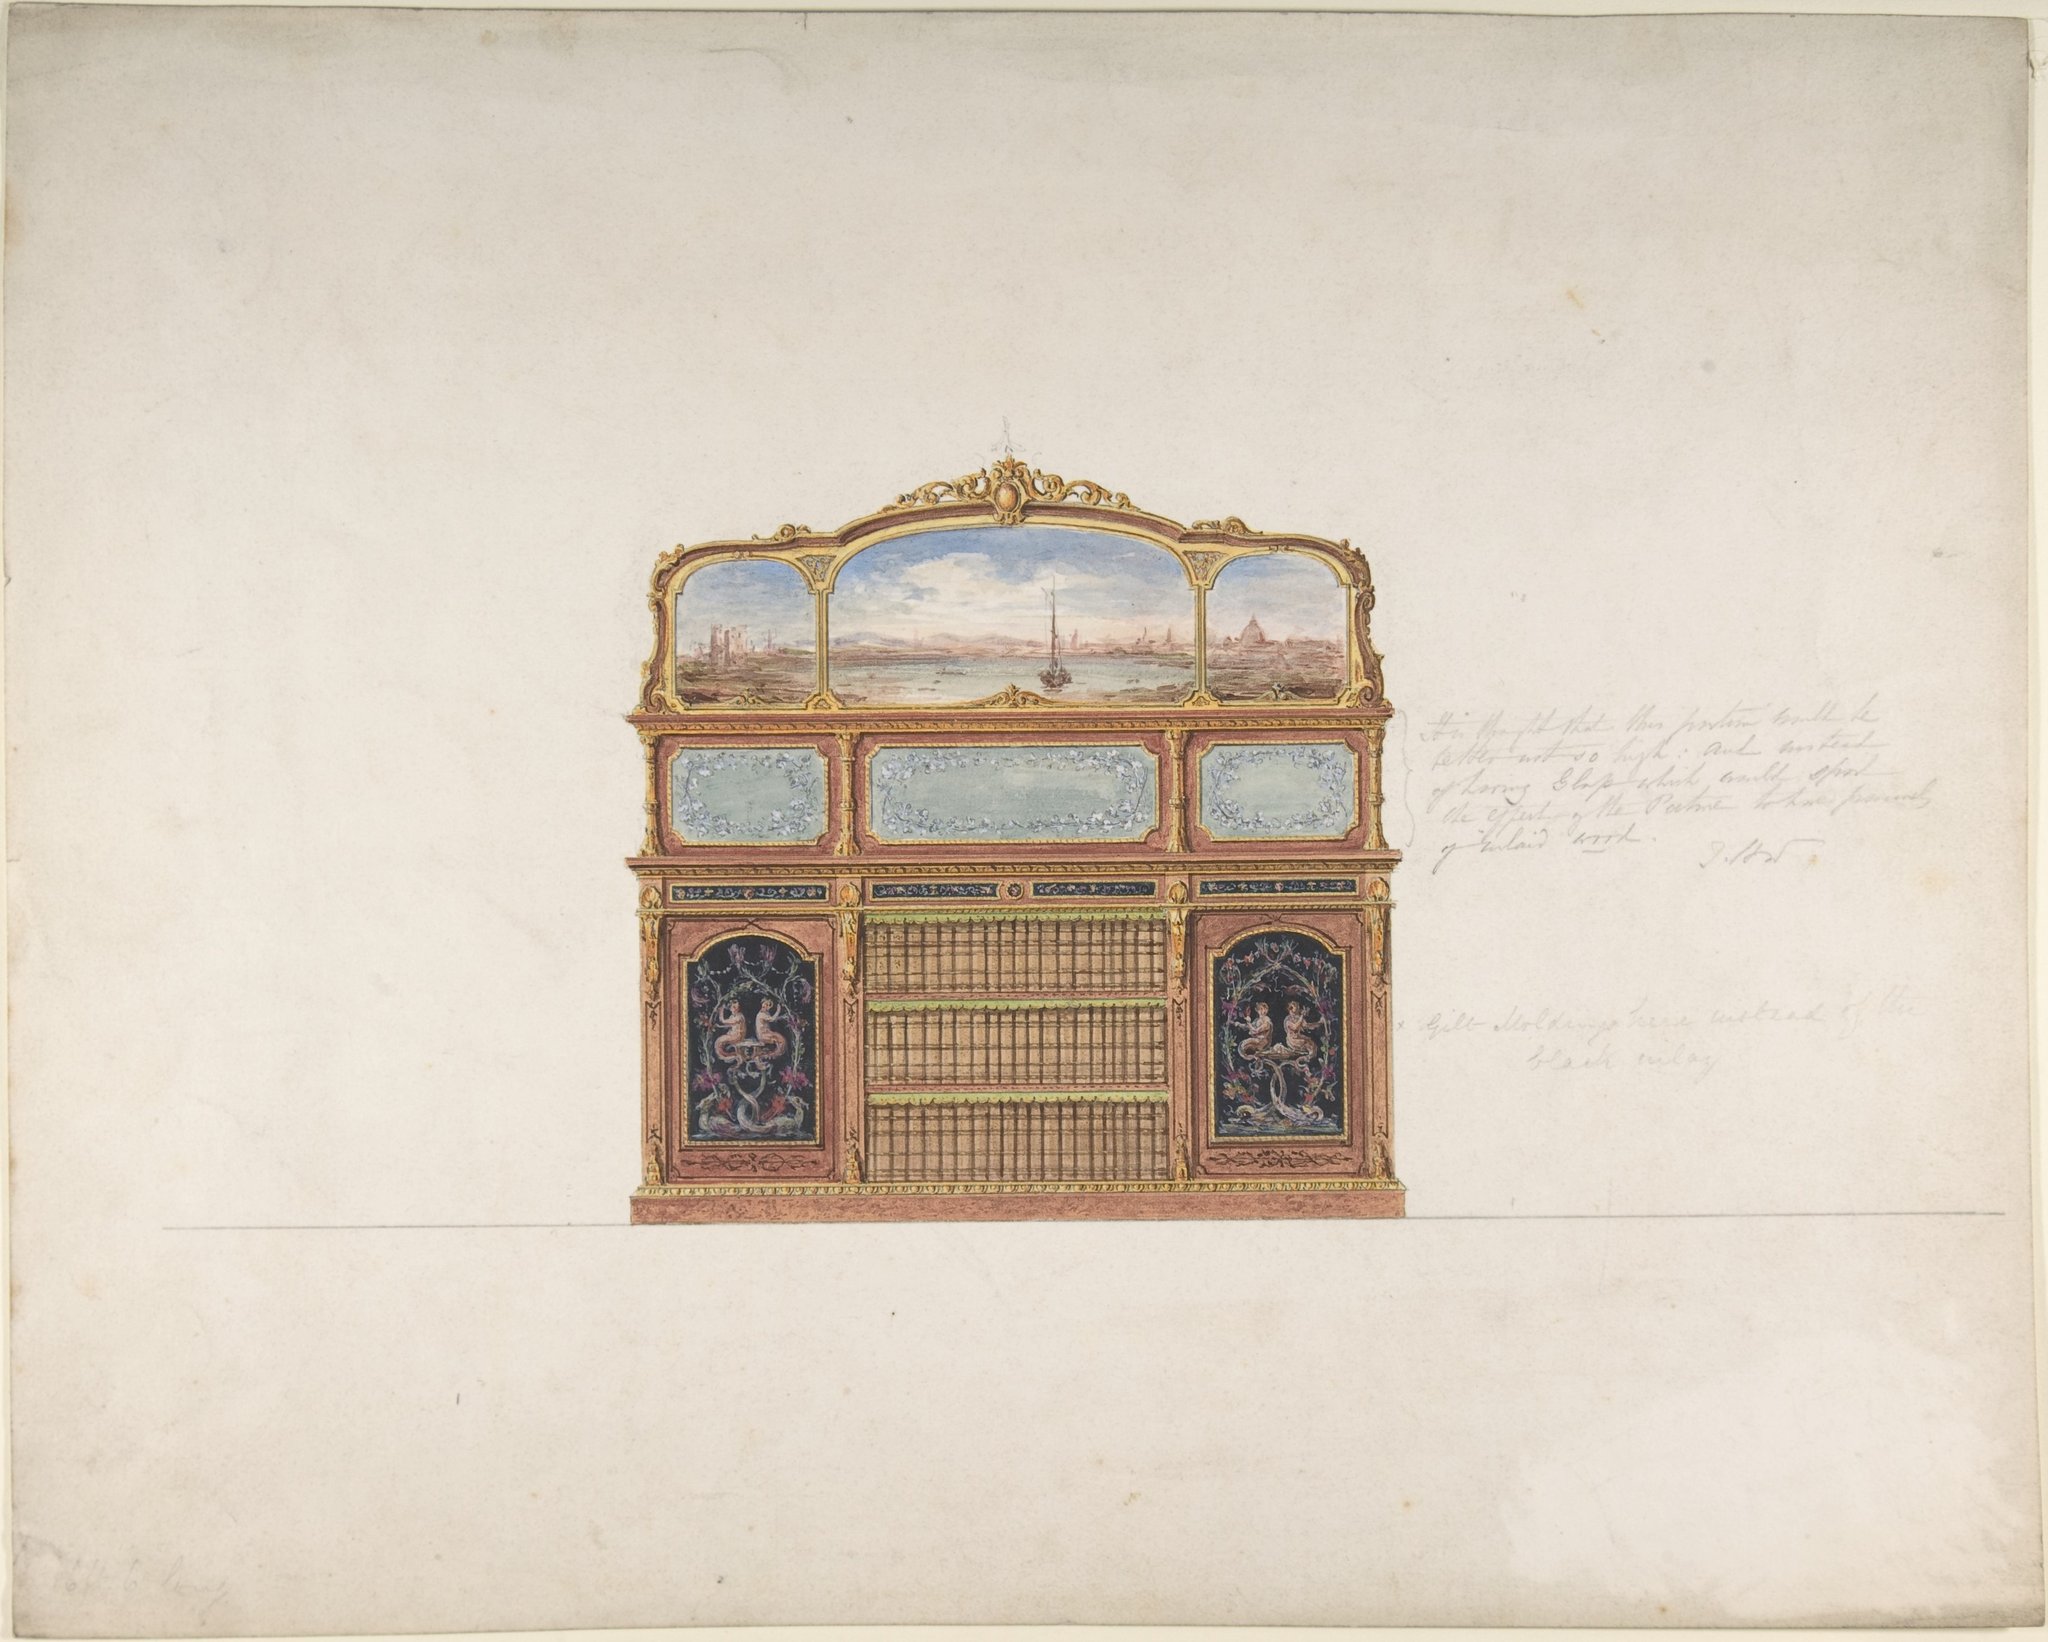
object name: drawing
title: Design for a Cabinet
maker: anonymous, british, 19th century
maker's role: artist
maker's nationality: british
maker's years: 1800-1900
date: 1830-1890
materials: gouache, ink, watercolor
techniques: pen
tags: boats,cabinets